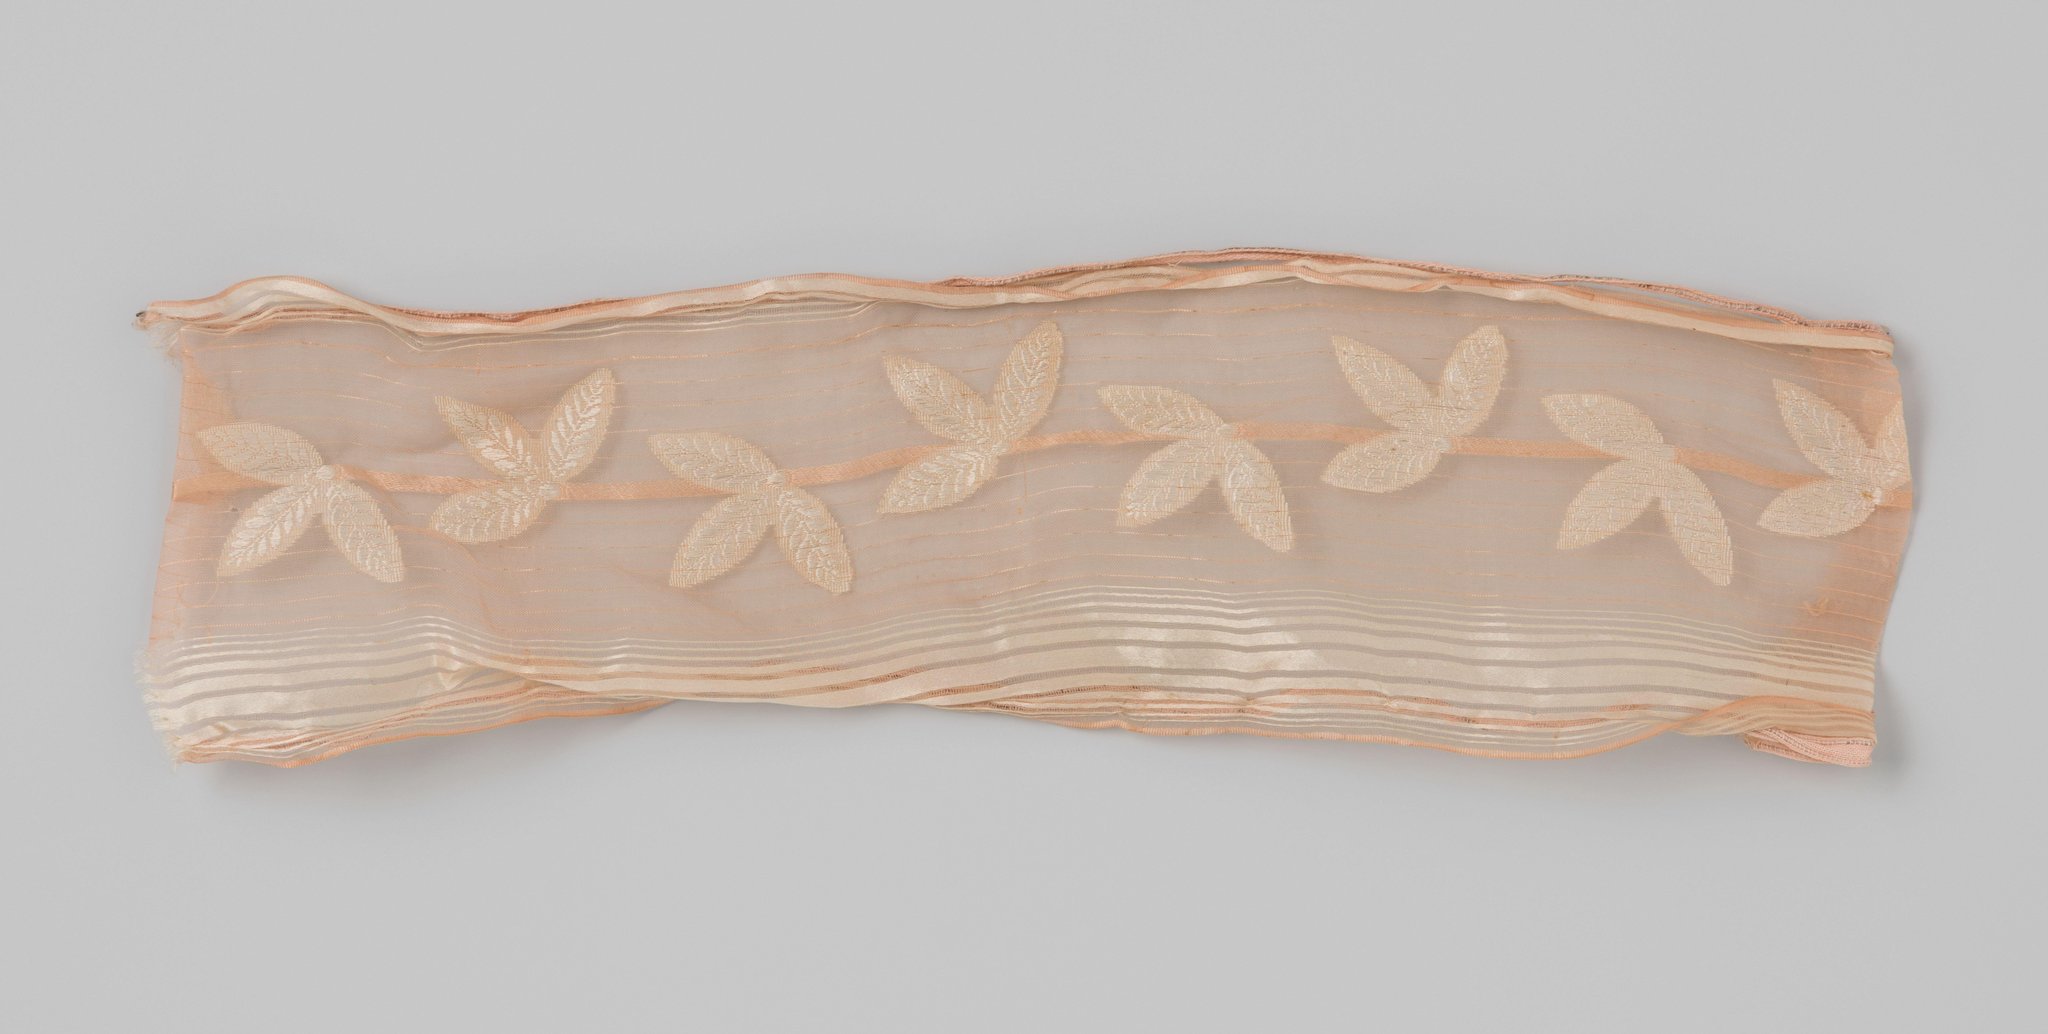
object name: womenswear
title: Lint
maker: Anonymous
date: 1830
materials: silk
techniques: embroidered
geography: europe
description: Linten van doorschijnend roze fijnmazige zijdengaas of tule met bladmotief uit ca. 1830, langs de randen verstevigd met ijzerdraad.